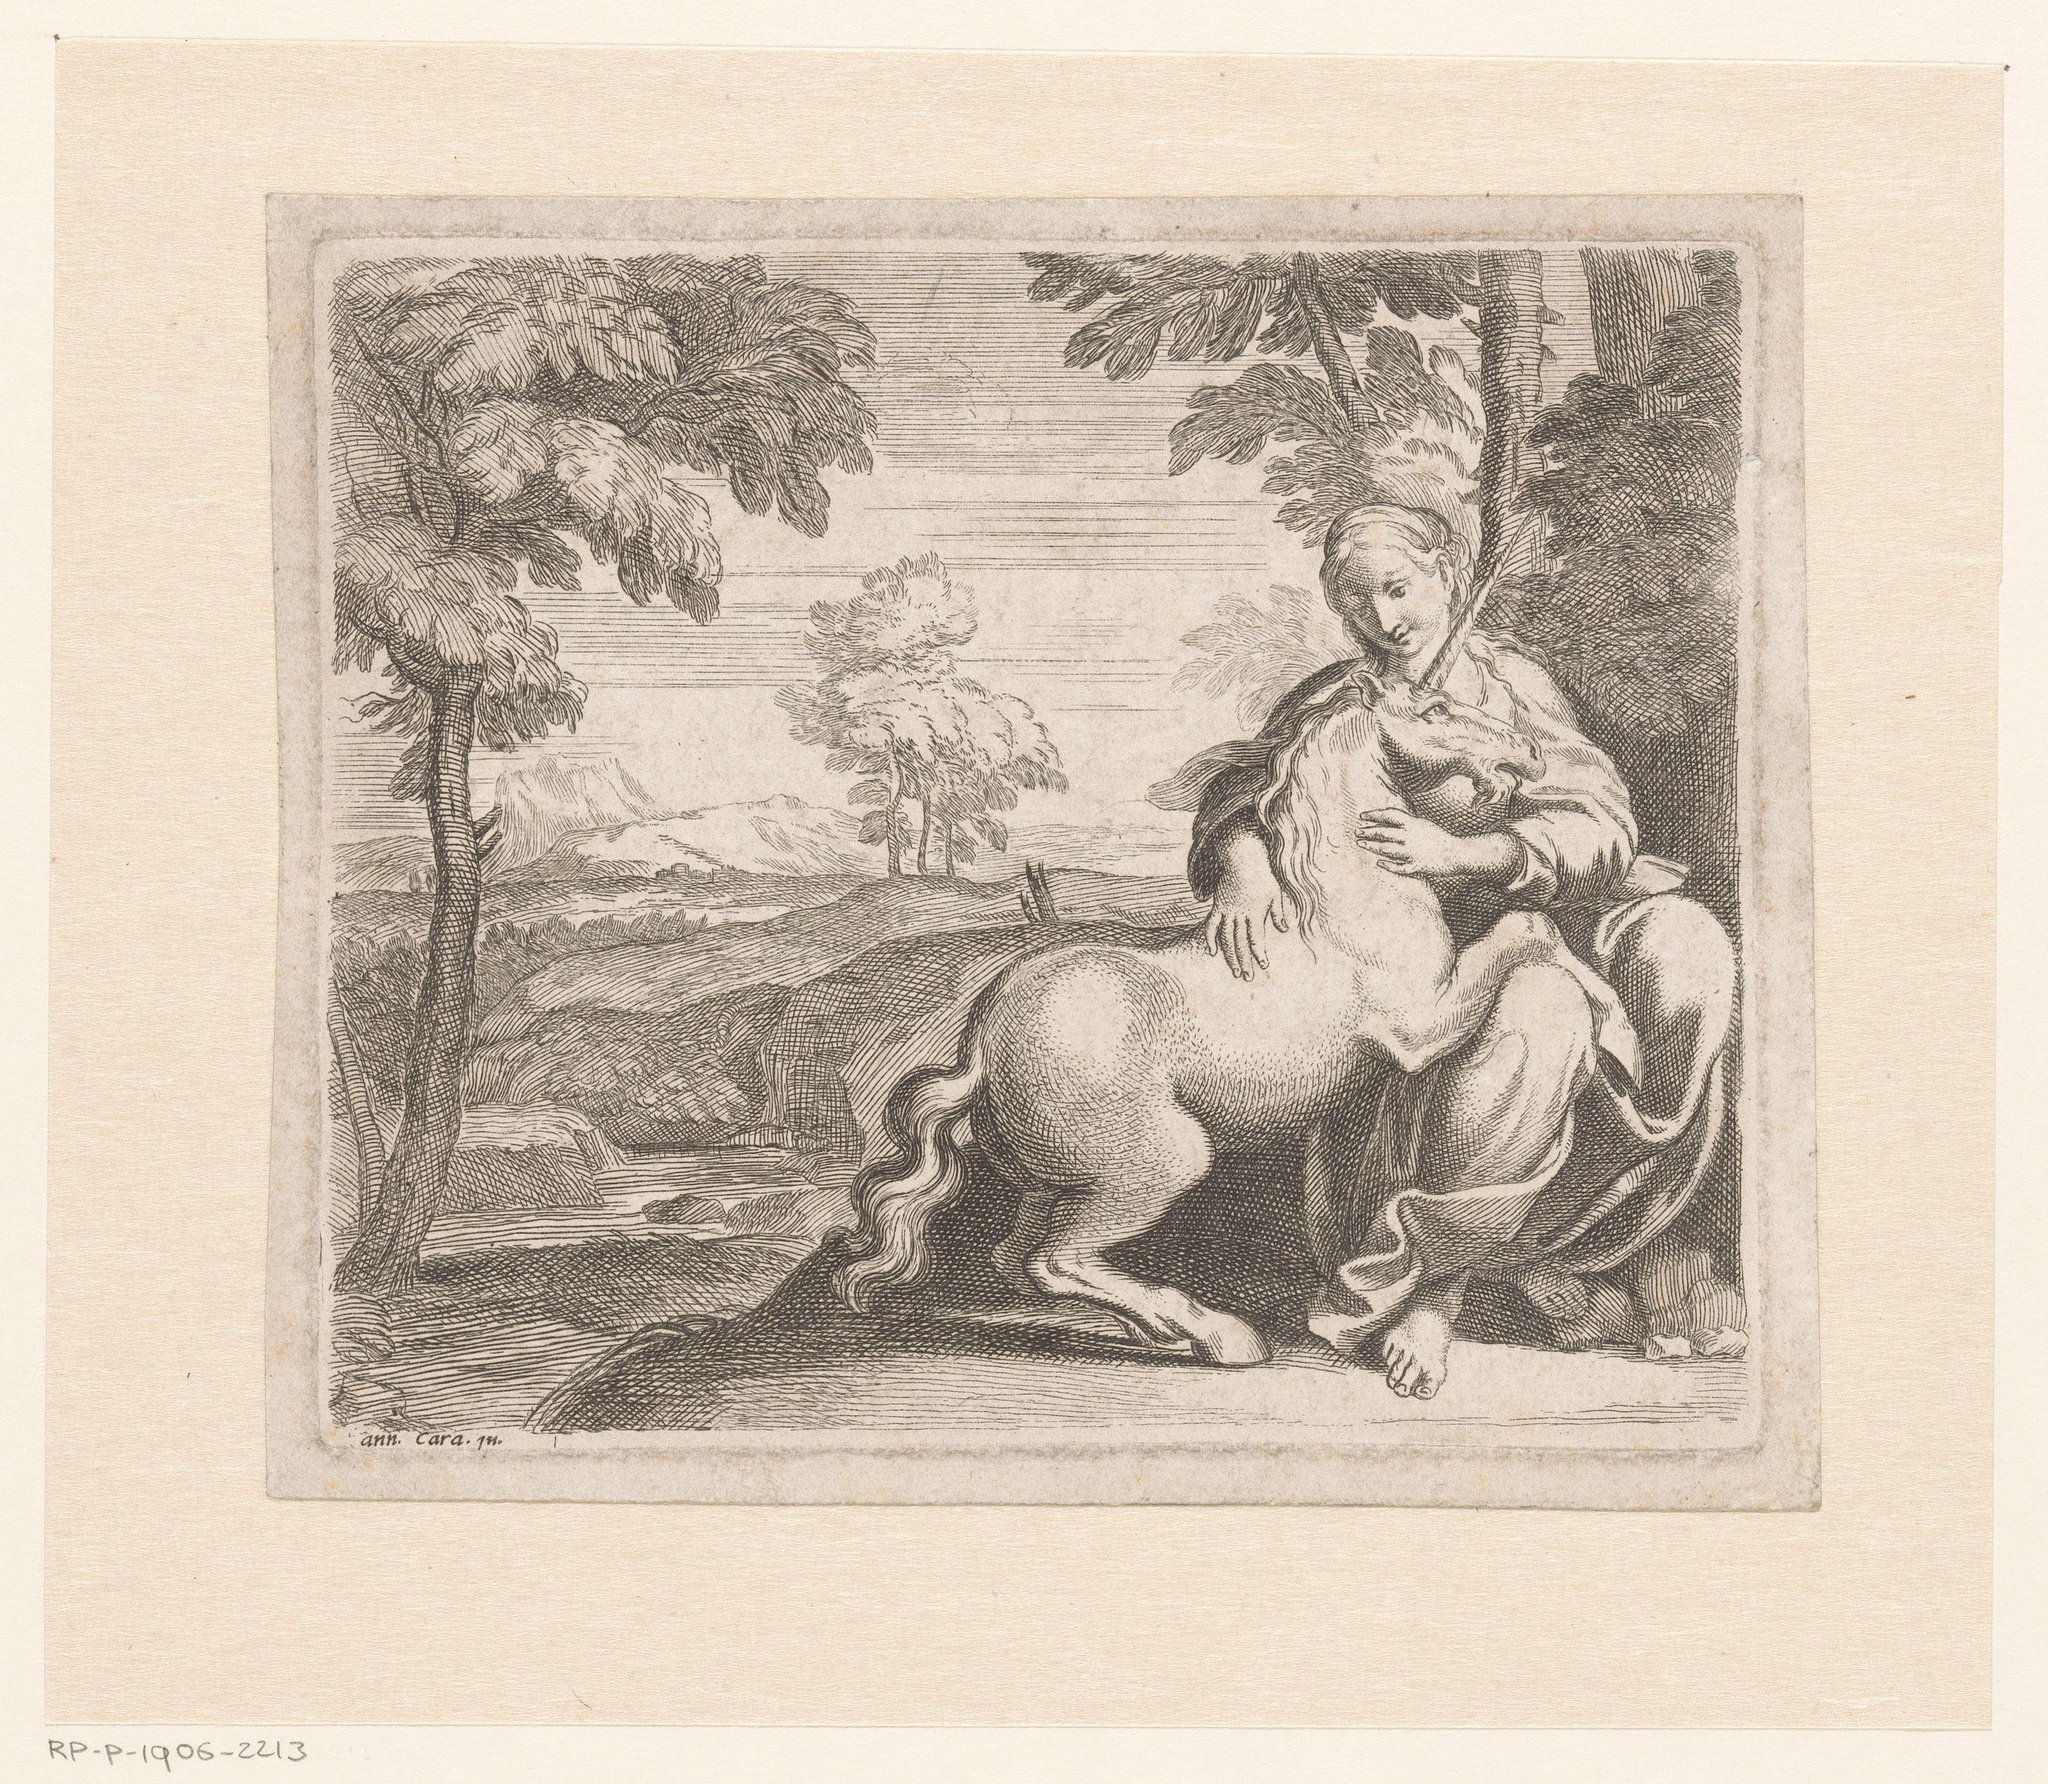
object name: print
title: Jonge vrouw met een eenhoorn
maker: Anonymous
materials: paper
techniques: engraving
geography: italy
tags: city-view, and landscape with man-made constructions, unicorn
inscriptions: collector's mark: Lugt 2228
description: Een jonge vrouw, zittend met een eenhoorn op haar schoot. Mogelijk betreft het de edelvrouw Giulia Farnese. Op de achtergrond een landschap.